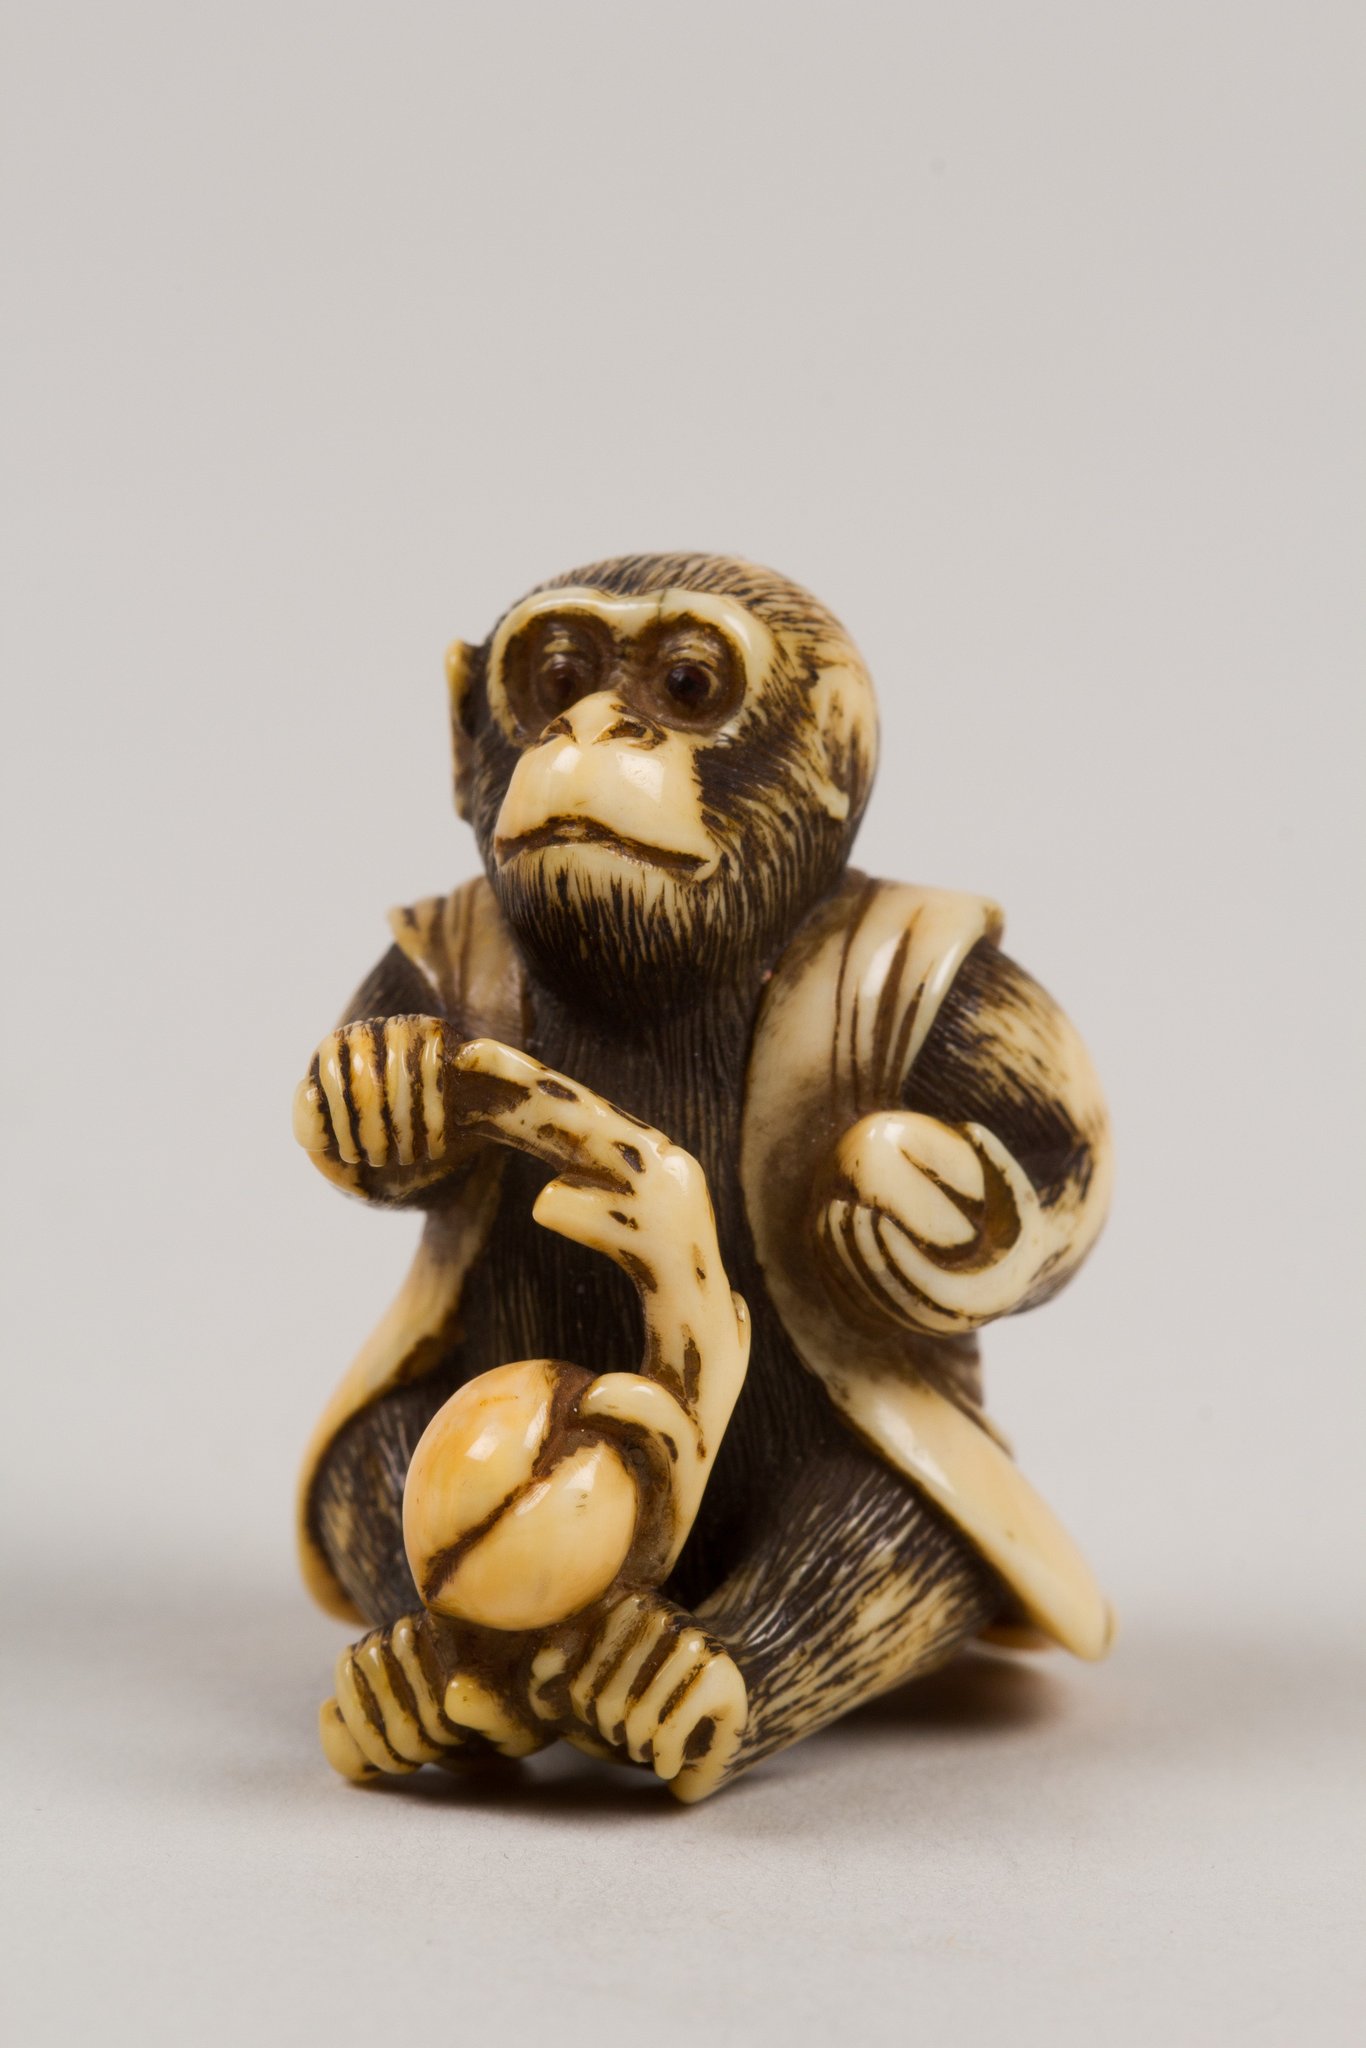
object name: netsuke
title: Netsuke in the Shape of a Monkey with a Peach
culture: japanese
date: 1801-1900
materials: ivory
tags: peaches,monkeys